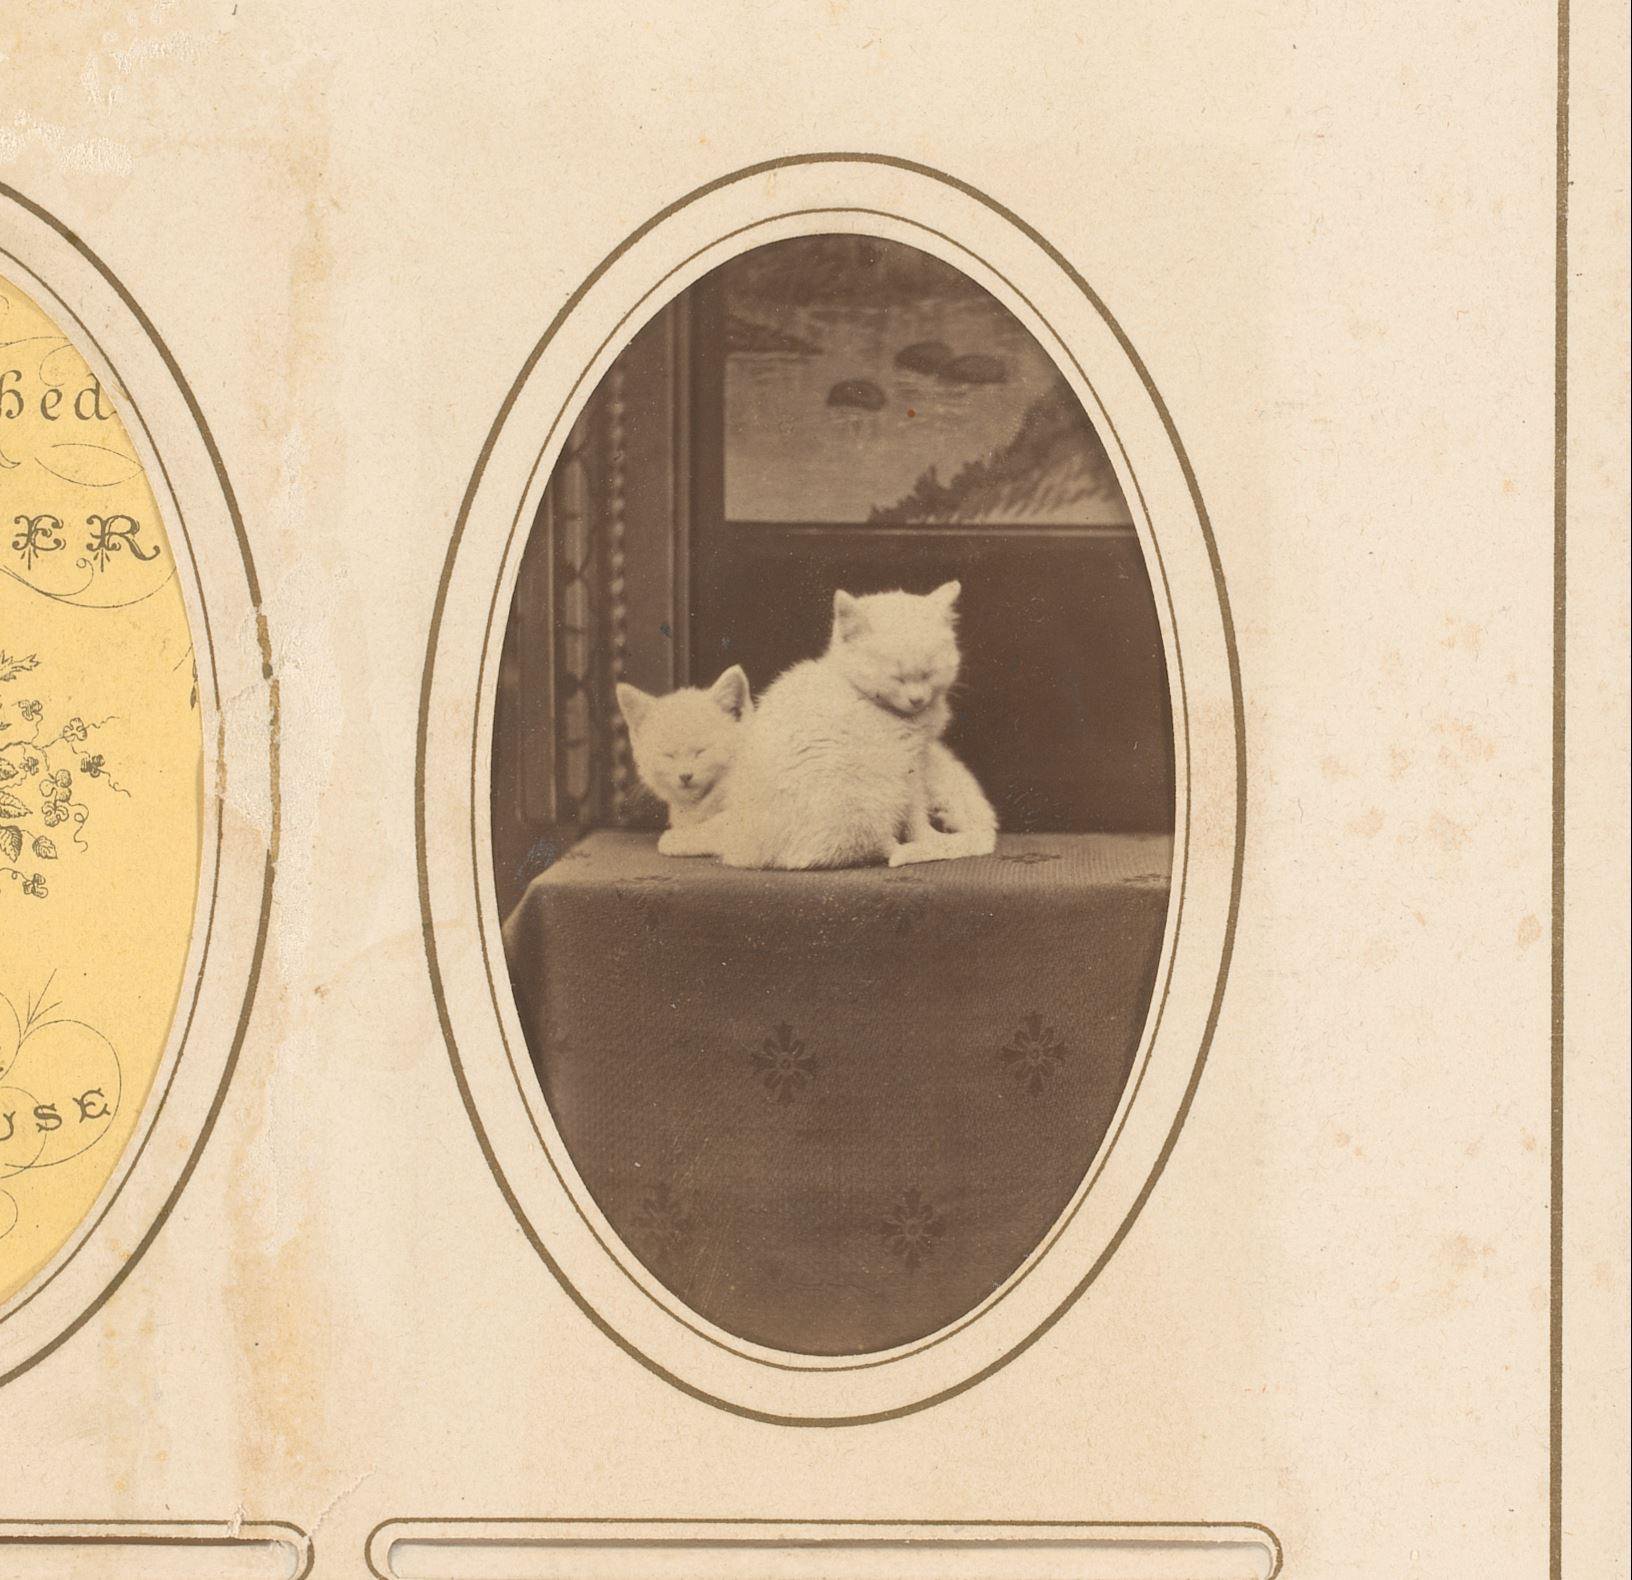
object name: carte de visite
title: Portret van twee katten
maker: Anonymous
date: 1860-1880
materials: cardboard, paper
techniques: albumen print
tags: cat, historical persons